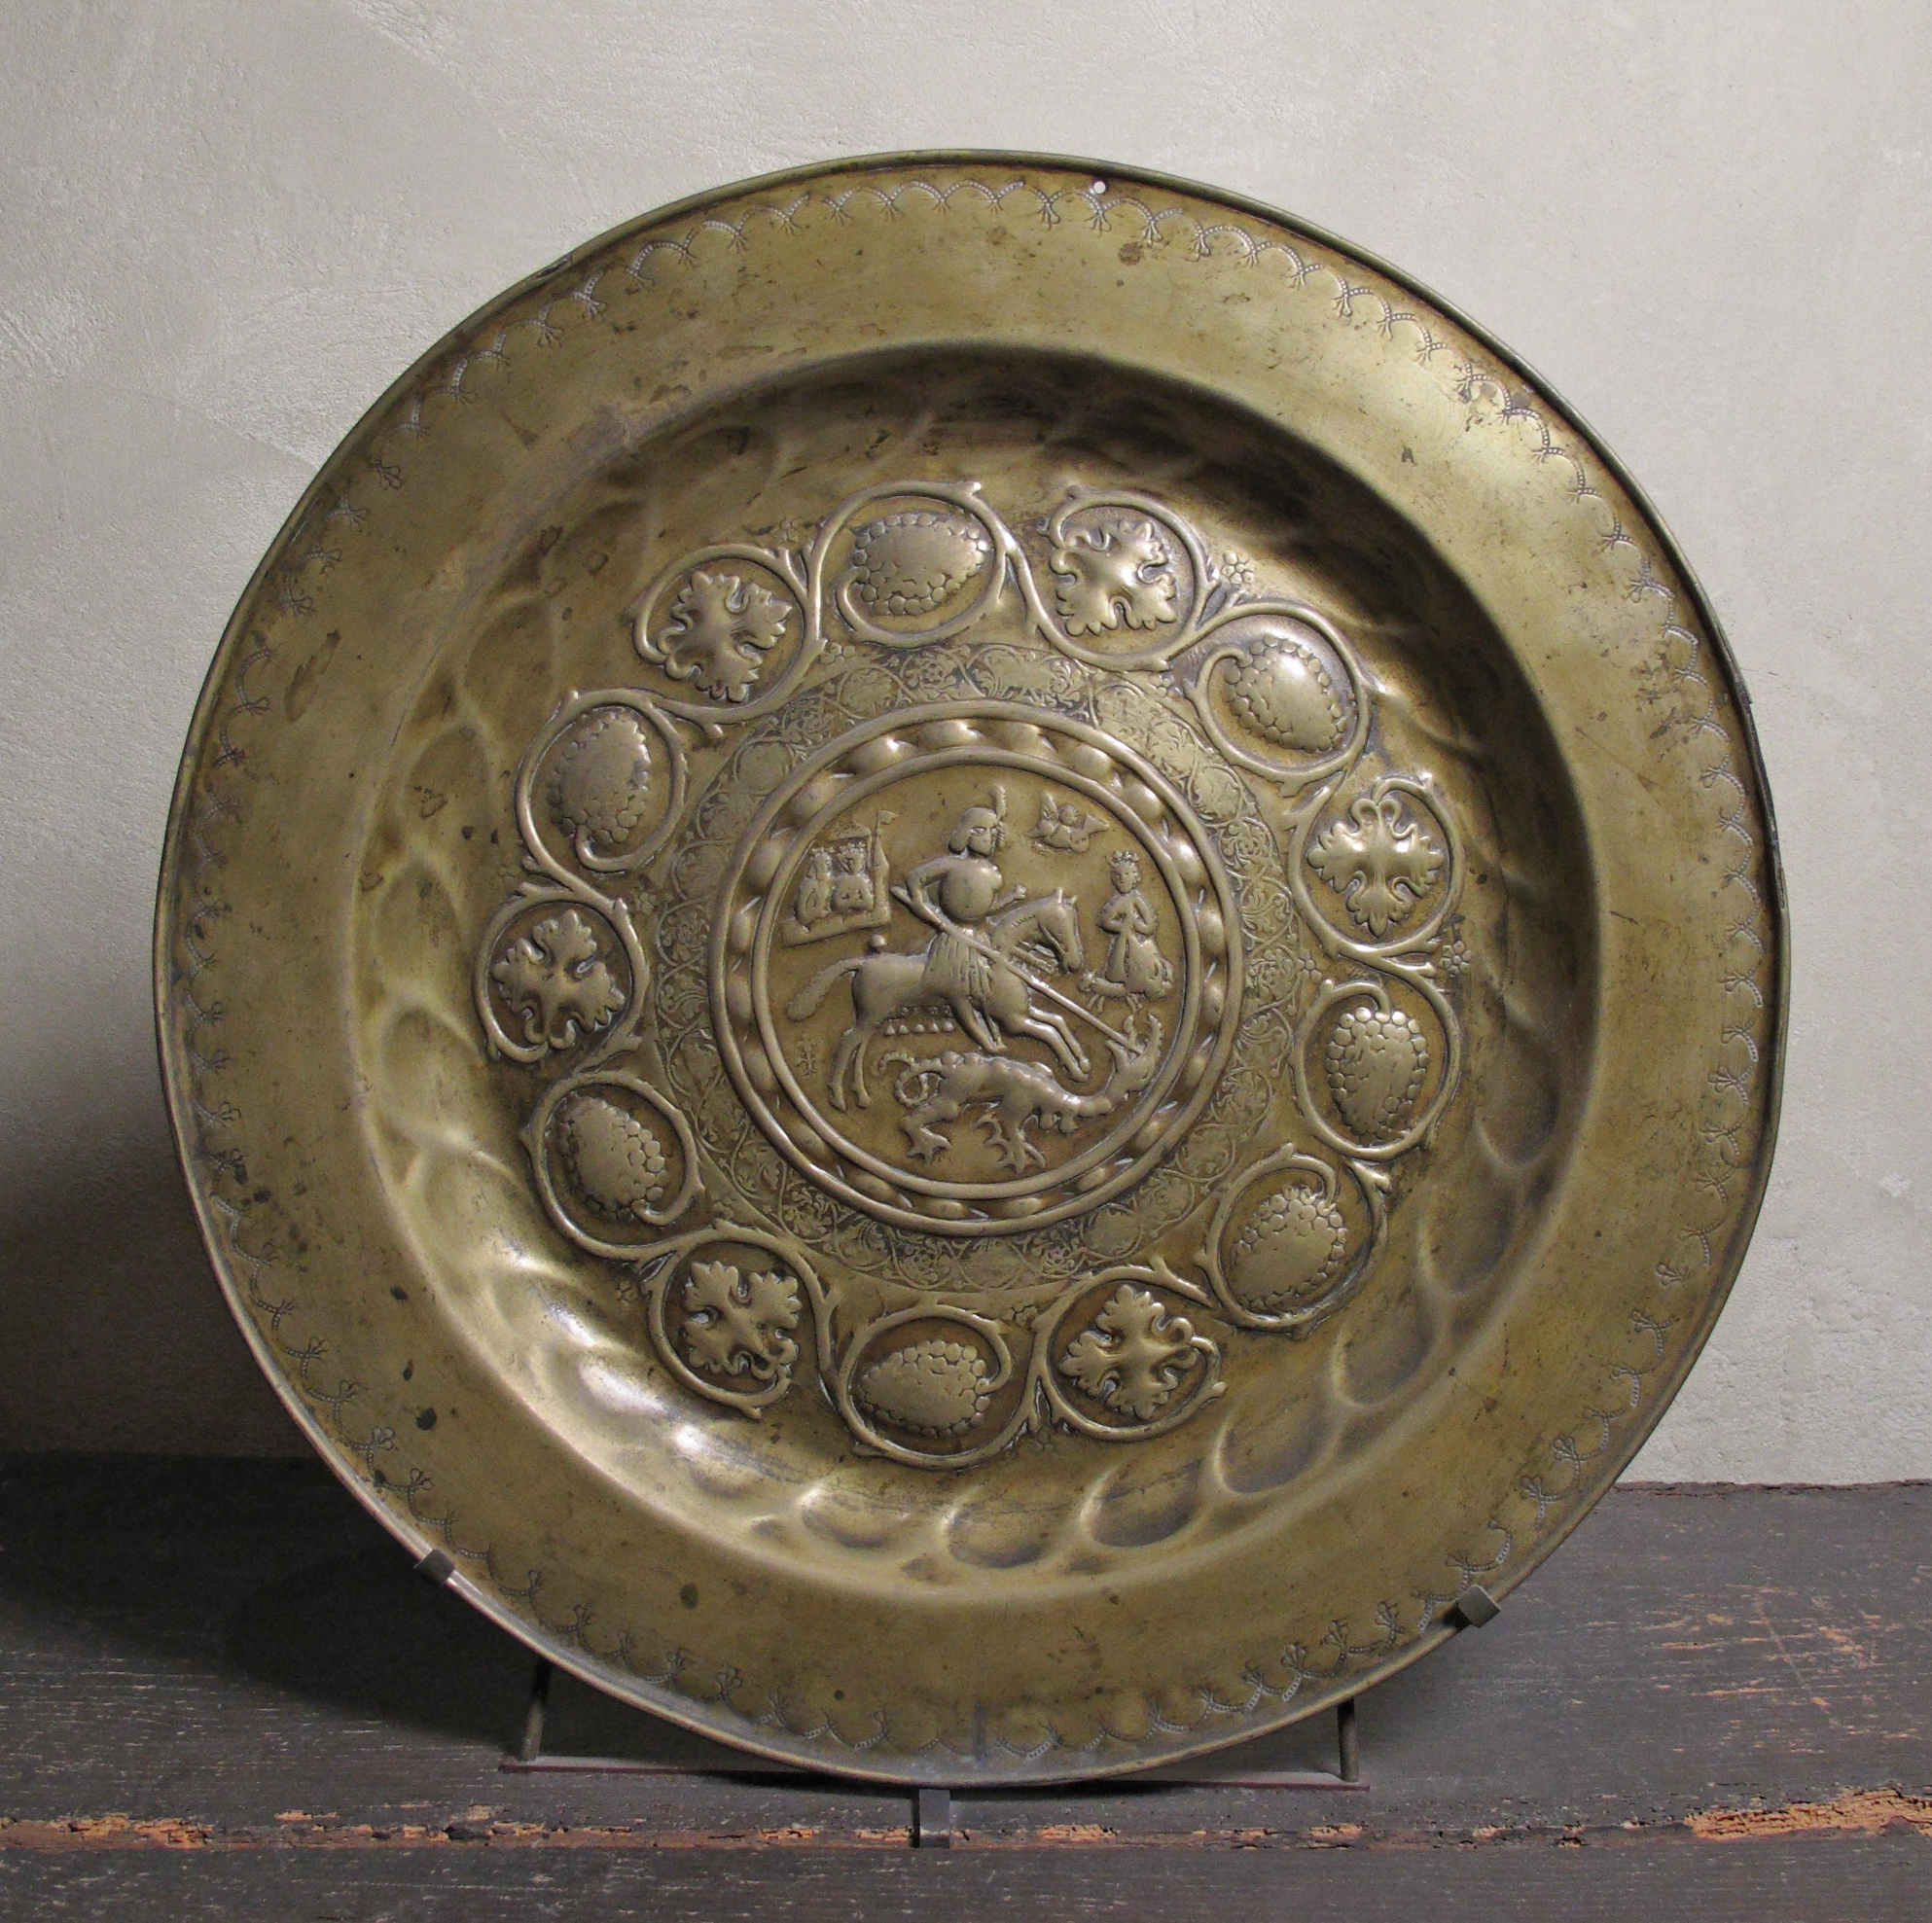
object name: plate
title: Charger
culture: german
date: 1467-1500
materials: brass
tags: human figures,horses